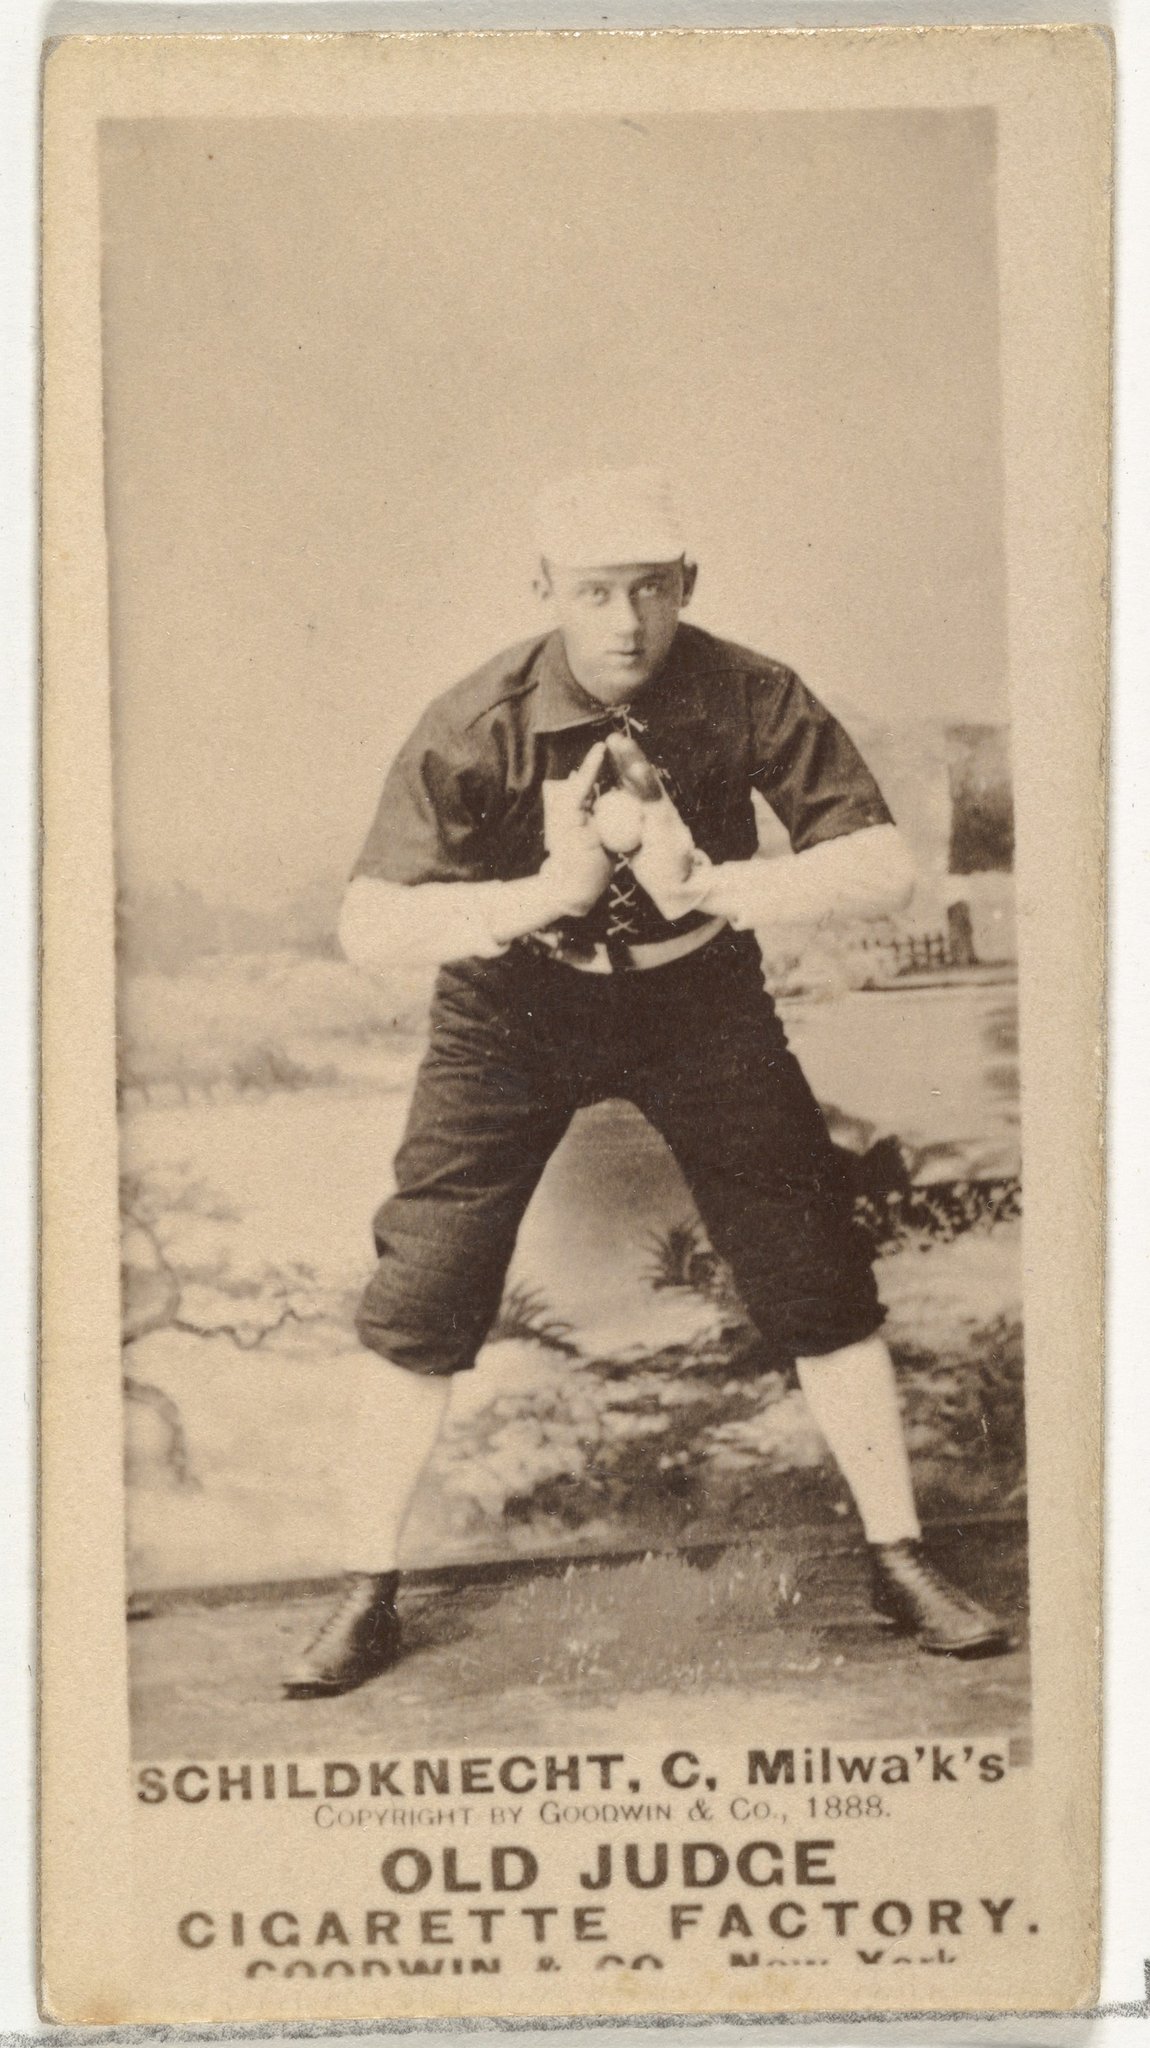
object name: baseball card, photograph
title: Schildknecht, Catcher, Milwaukee, from the Old Judge series (N172) for Old Judge Cigarettes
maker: goodwin & company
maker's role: publisher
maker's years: 1850-1950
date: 1888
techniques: albumen silver print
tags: men,portraits,baseball,athletes